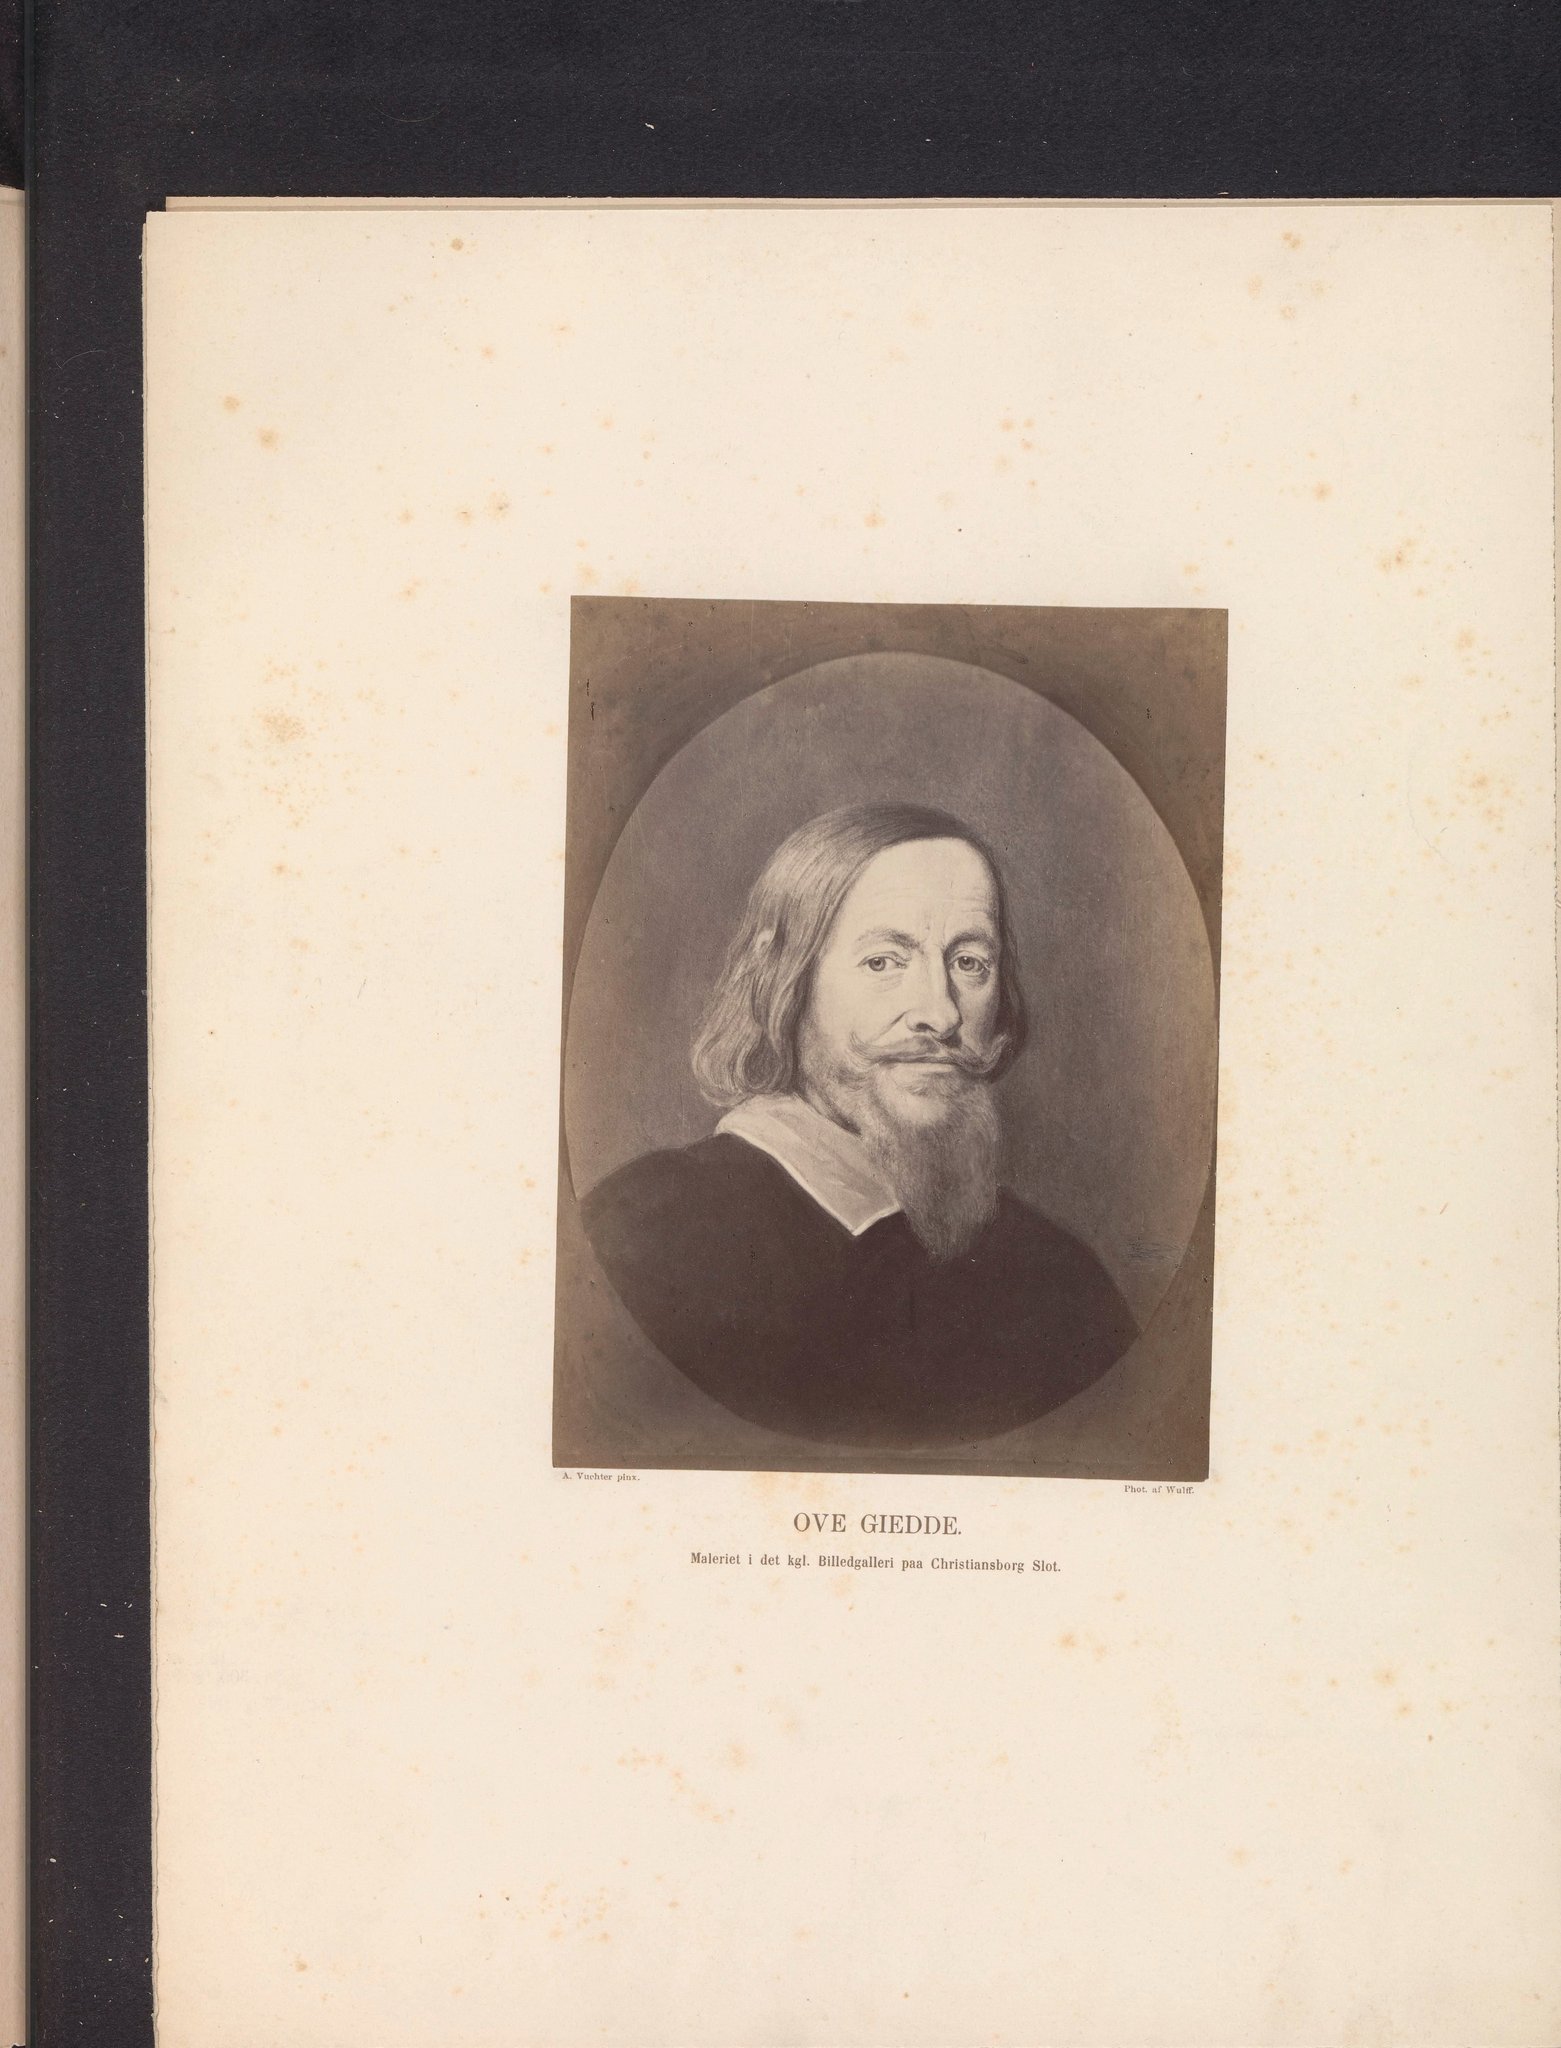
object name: photograph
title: Fotoreproductie van een schilderij, voorstellende een portret van Ove Gjedde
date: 1858-1862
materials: photographic support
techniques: albumen print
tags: physician, doctor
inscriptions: inscription: ‘Maleriet i det kgl. Billedgaleri paa Christiansborg Slot.’